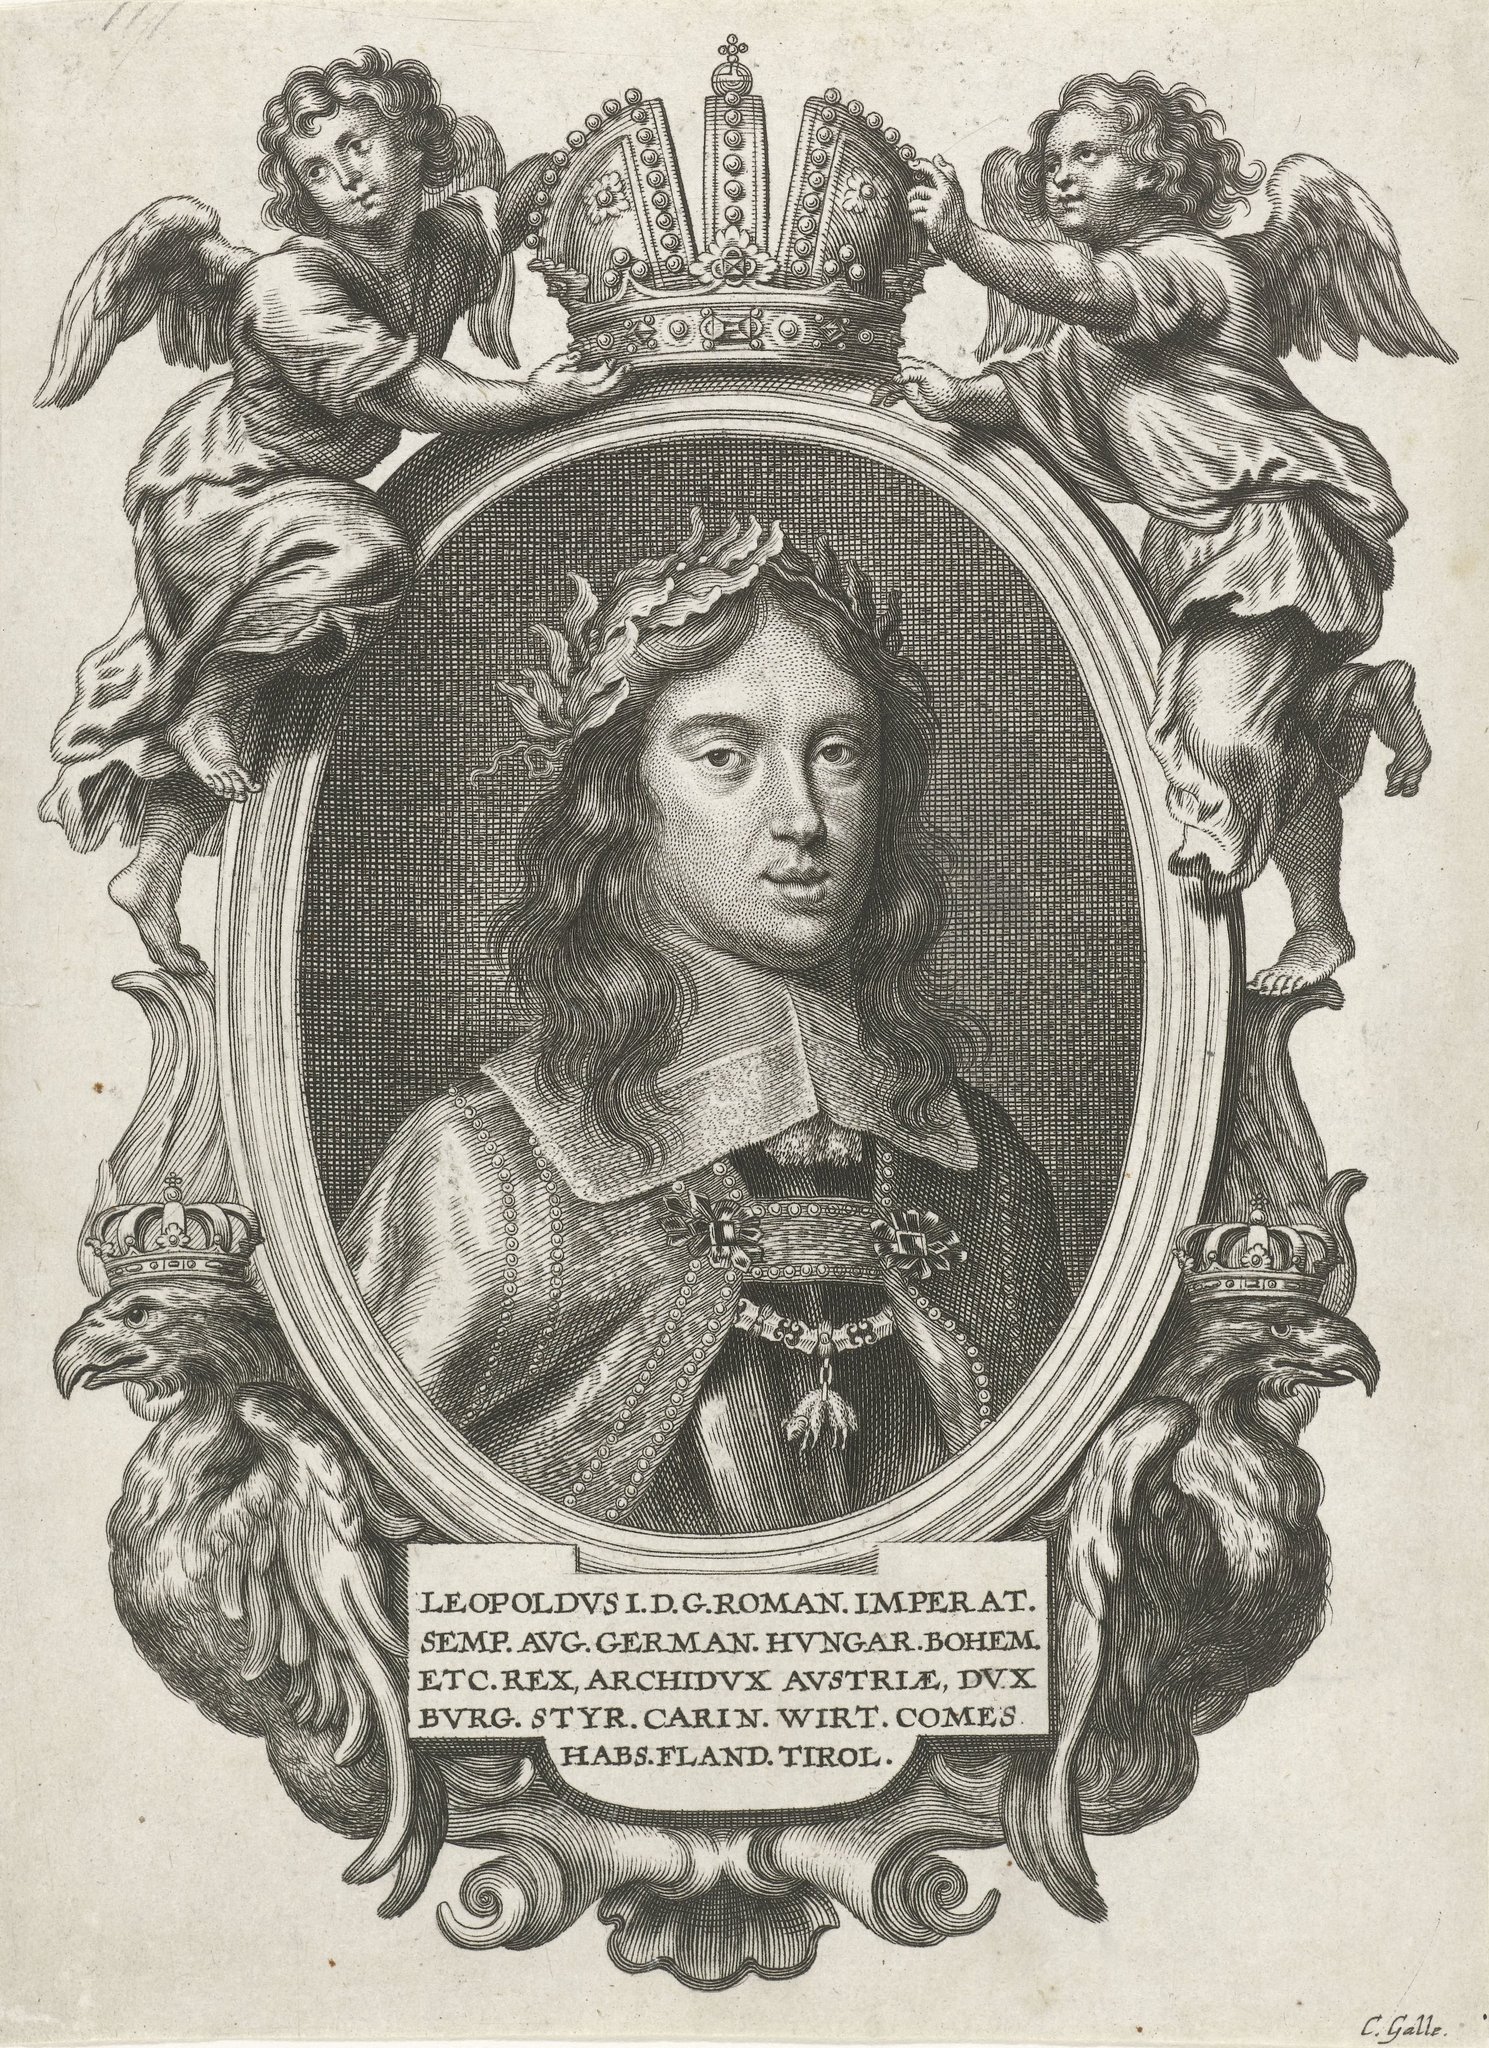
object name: print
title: Portret van keizer Leopold I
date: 1658-1678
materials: paper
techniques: engraving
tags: vienna, leopold i (keizer van duitsland)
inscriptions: collector's mark: Lugt 2228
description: Portret van keizer Leopold I met lauwerkrans en ketting van het Gulden Vlies. Portret in ovaal met een sierlijst van engelen die de keizerskroon vasthouden en twee gekroonde adelaars.